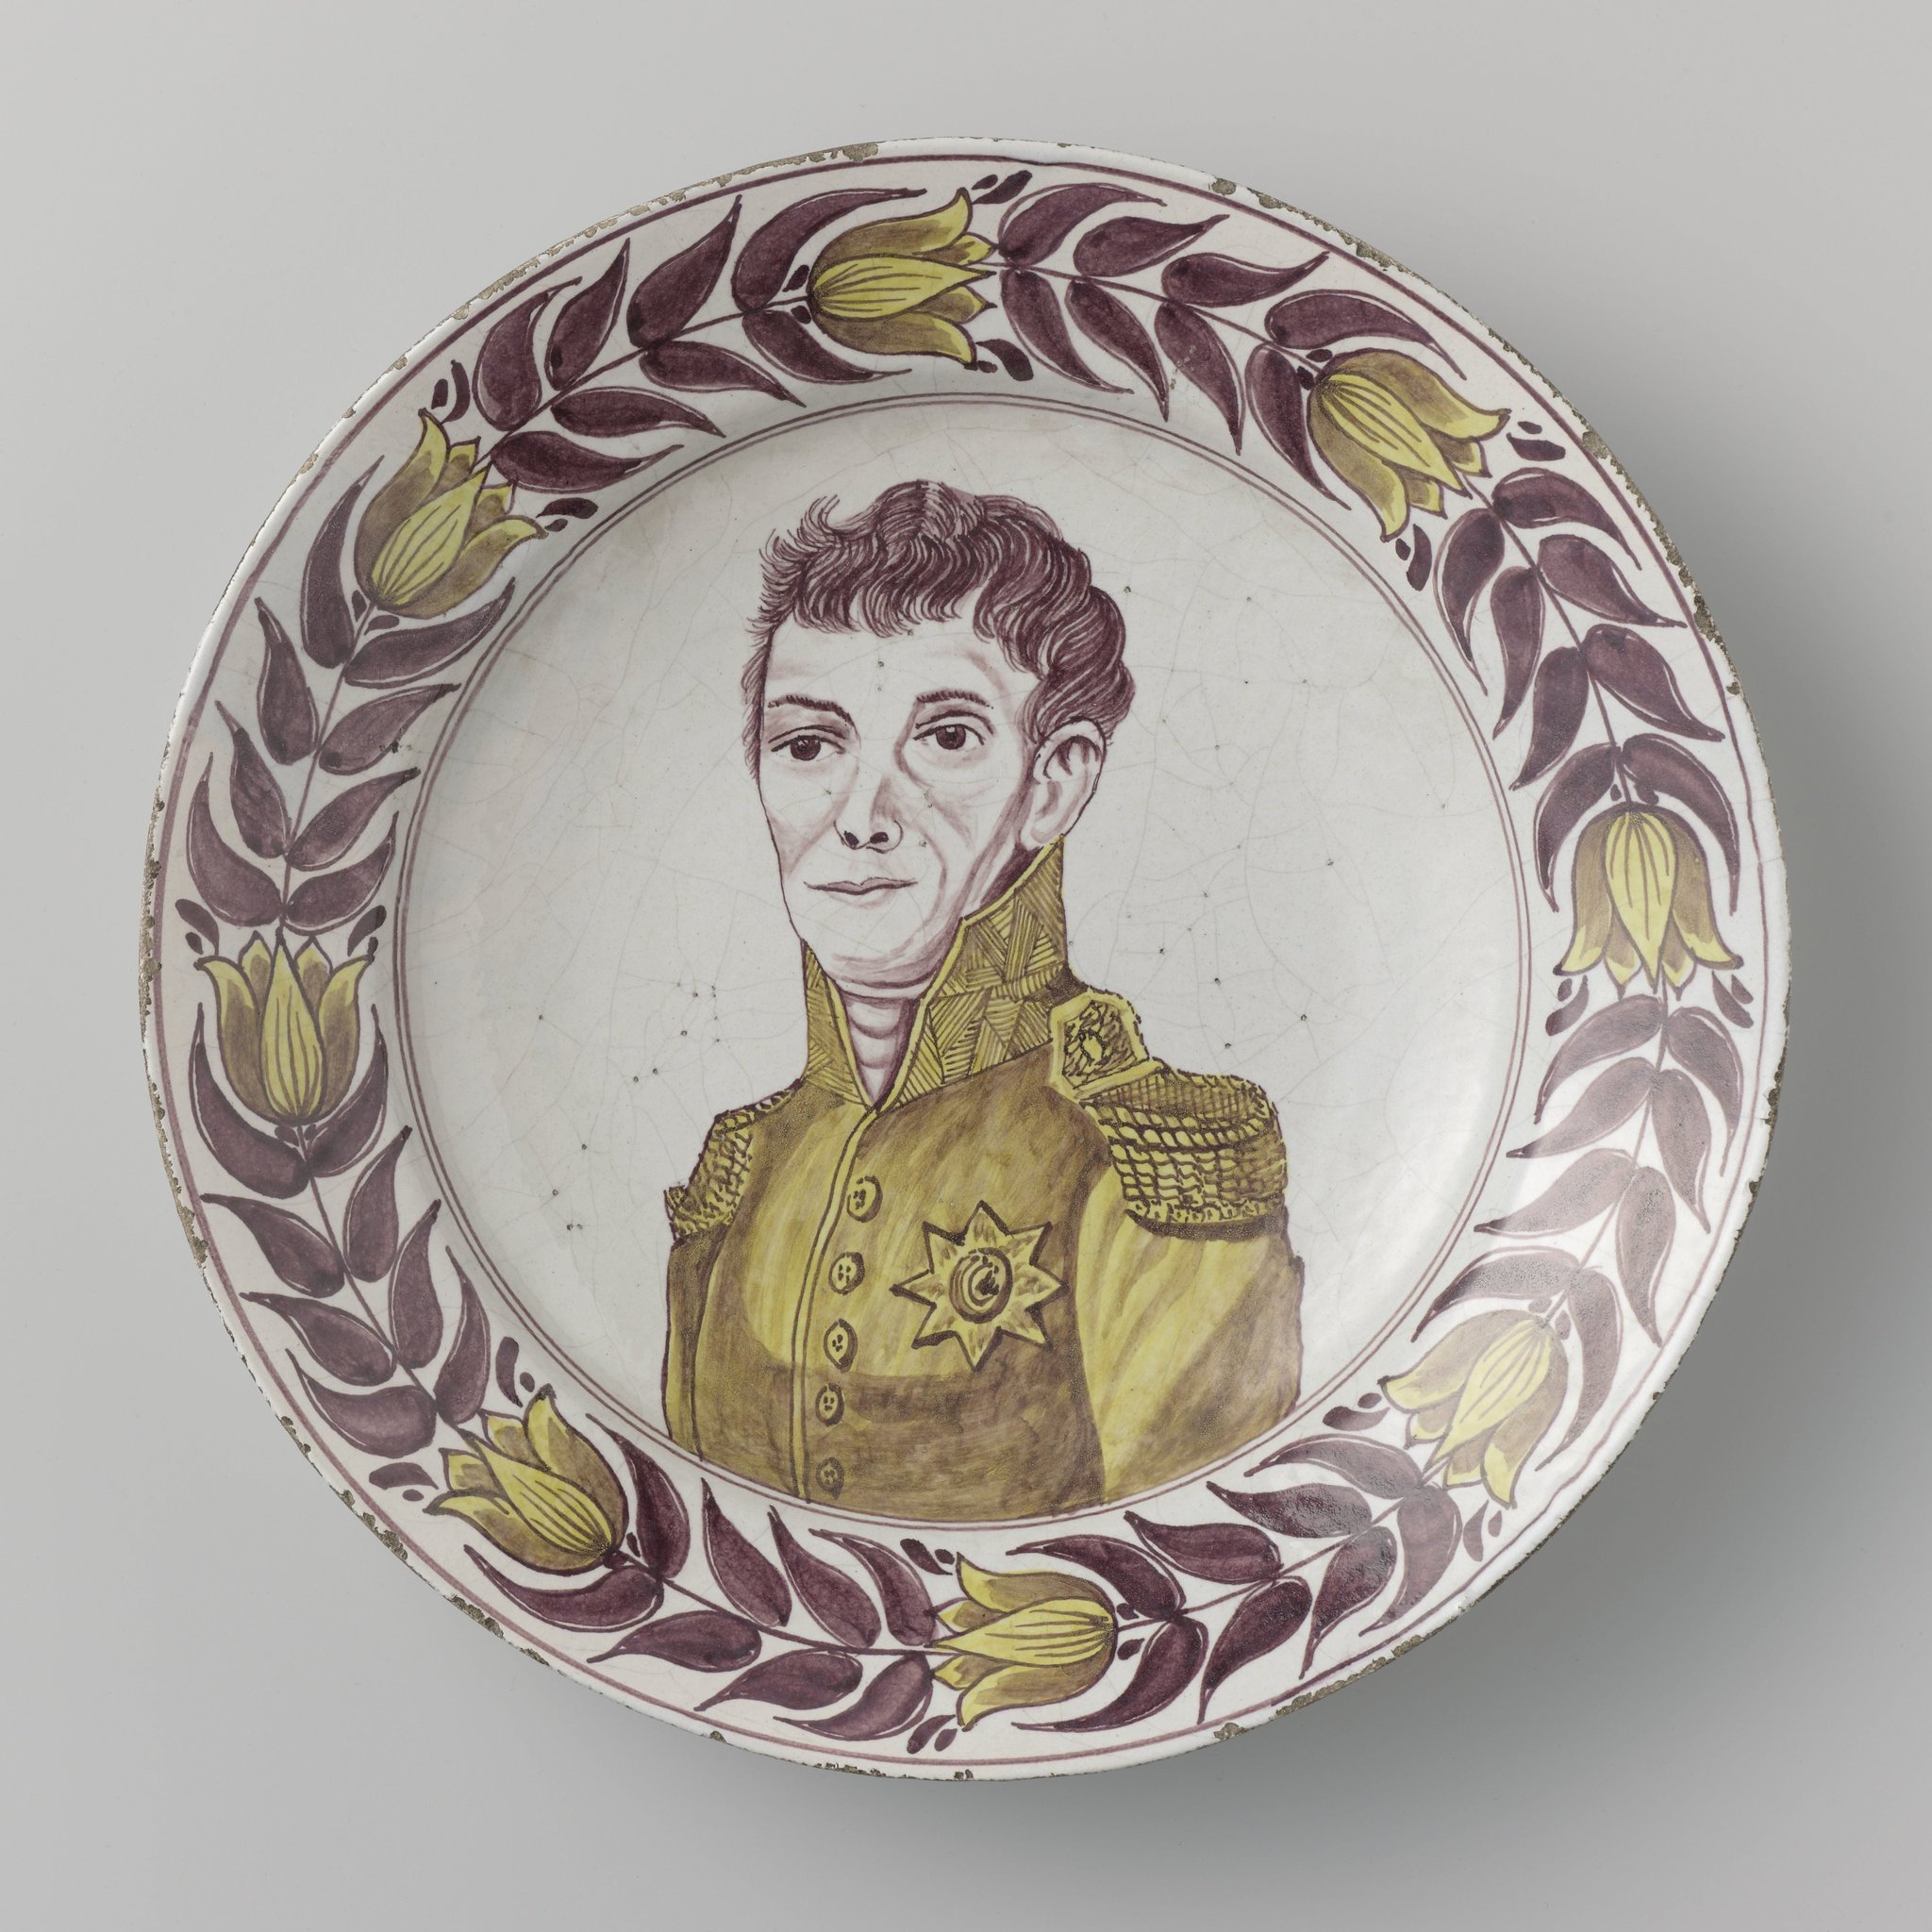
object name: plate dish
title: Portret van Willem I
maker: Anonymous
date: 1800-1825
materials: earthenware, glaze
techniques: painted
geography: netherlands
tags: the hague, berlin, william i of the netherlands, historical persons, king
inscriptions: mark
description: Schotel van (Delfts?) aardewerk beschilderd in mangaan en geel op de witte tinglazuur. Op het plat het portret van koning Willem I. Op de rand een krans van tulpen. Gemerkt. Het object is VALS.